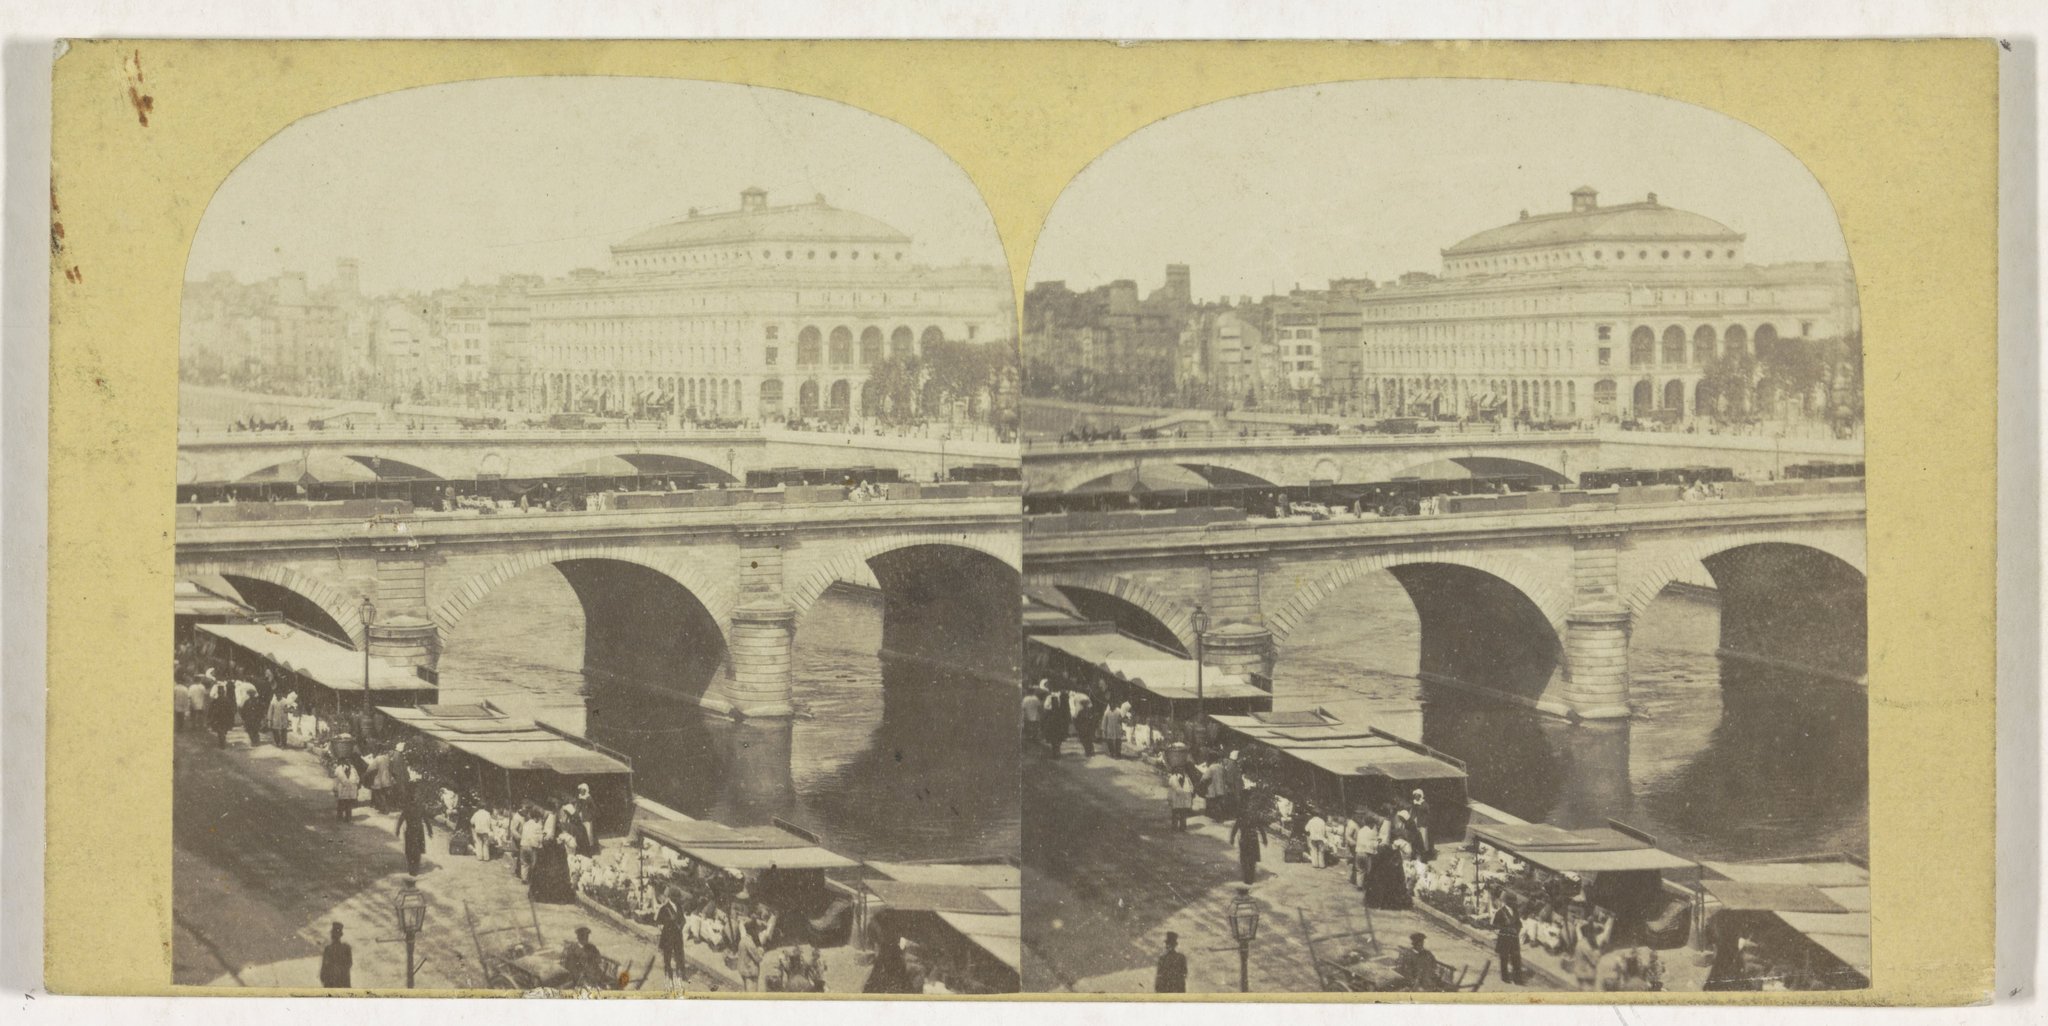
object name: stereograph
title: Brug met daarachter het Théatre de Châtelet, Parijs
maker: Anonymous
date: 1855-1865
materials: cardboard, paper, photographic support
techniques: albumen print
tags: paris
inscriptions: inscription: ‘€8-’, label: ‘Paris instantané. Théâtre du Châtetet.’